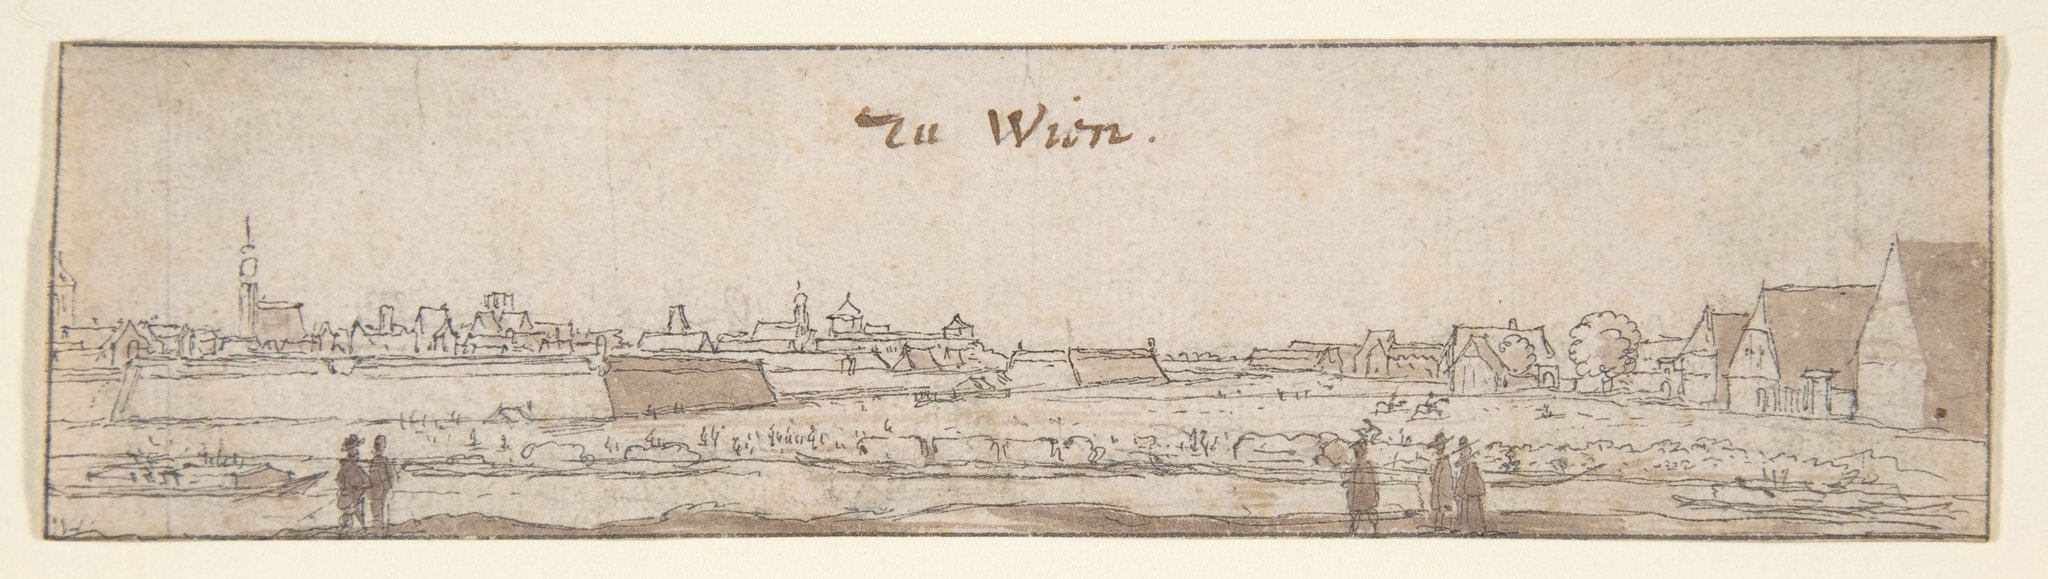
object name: drawing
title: View of Vienna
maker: wenceslaus hollar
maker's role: artist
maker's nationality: bohemian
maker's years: 1607-1677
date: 1624-1677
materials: chalk, ink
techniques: pen, wash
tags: human figures,houses